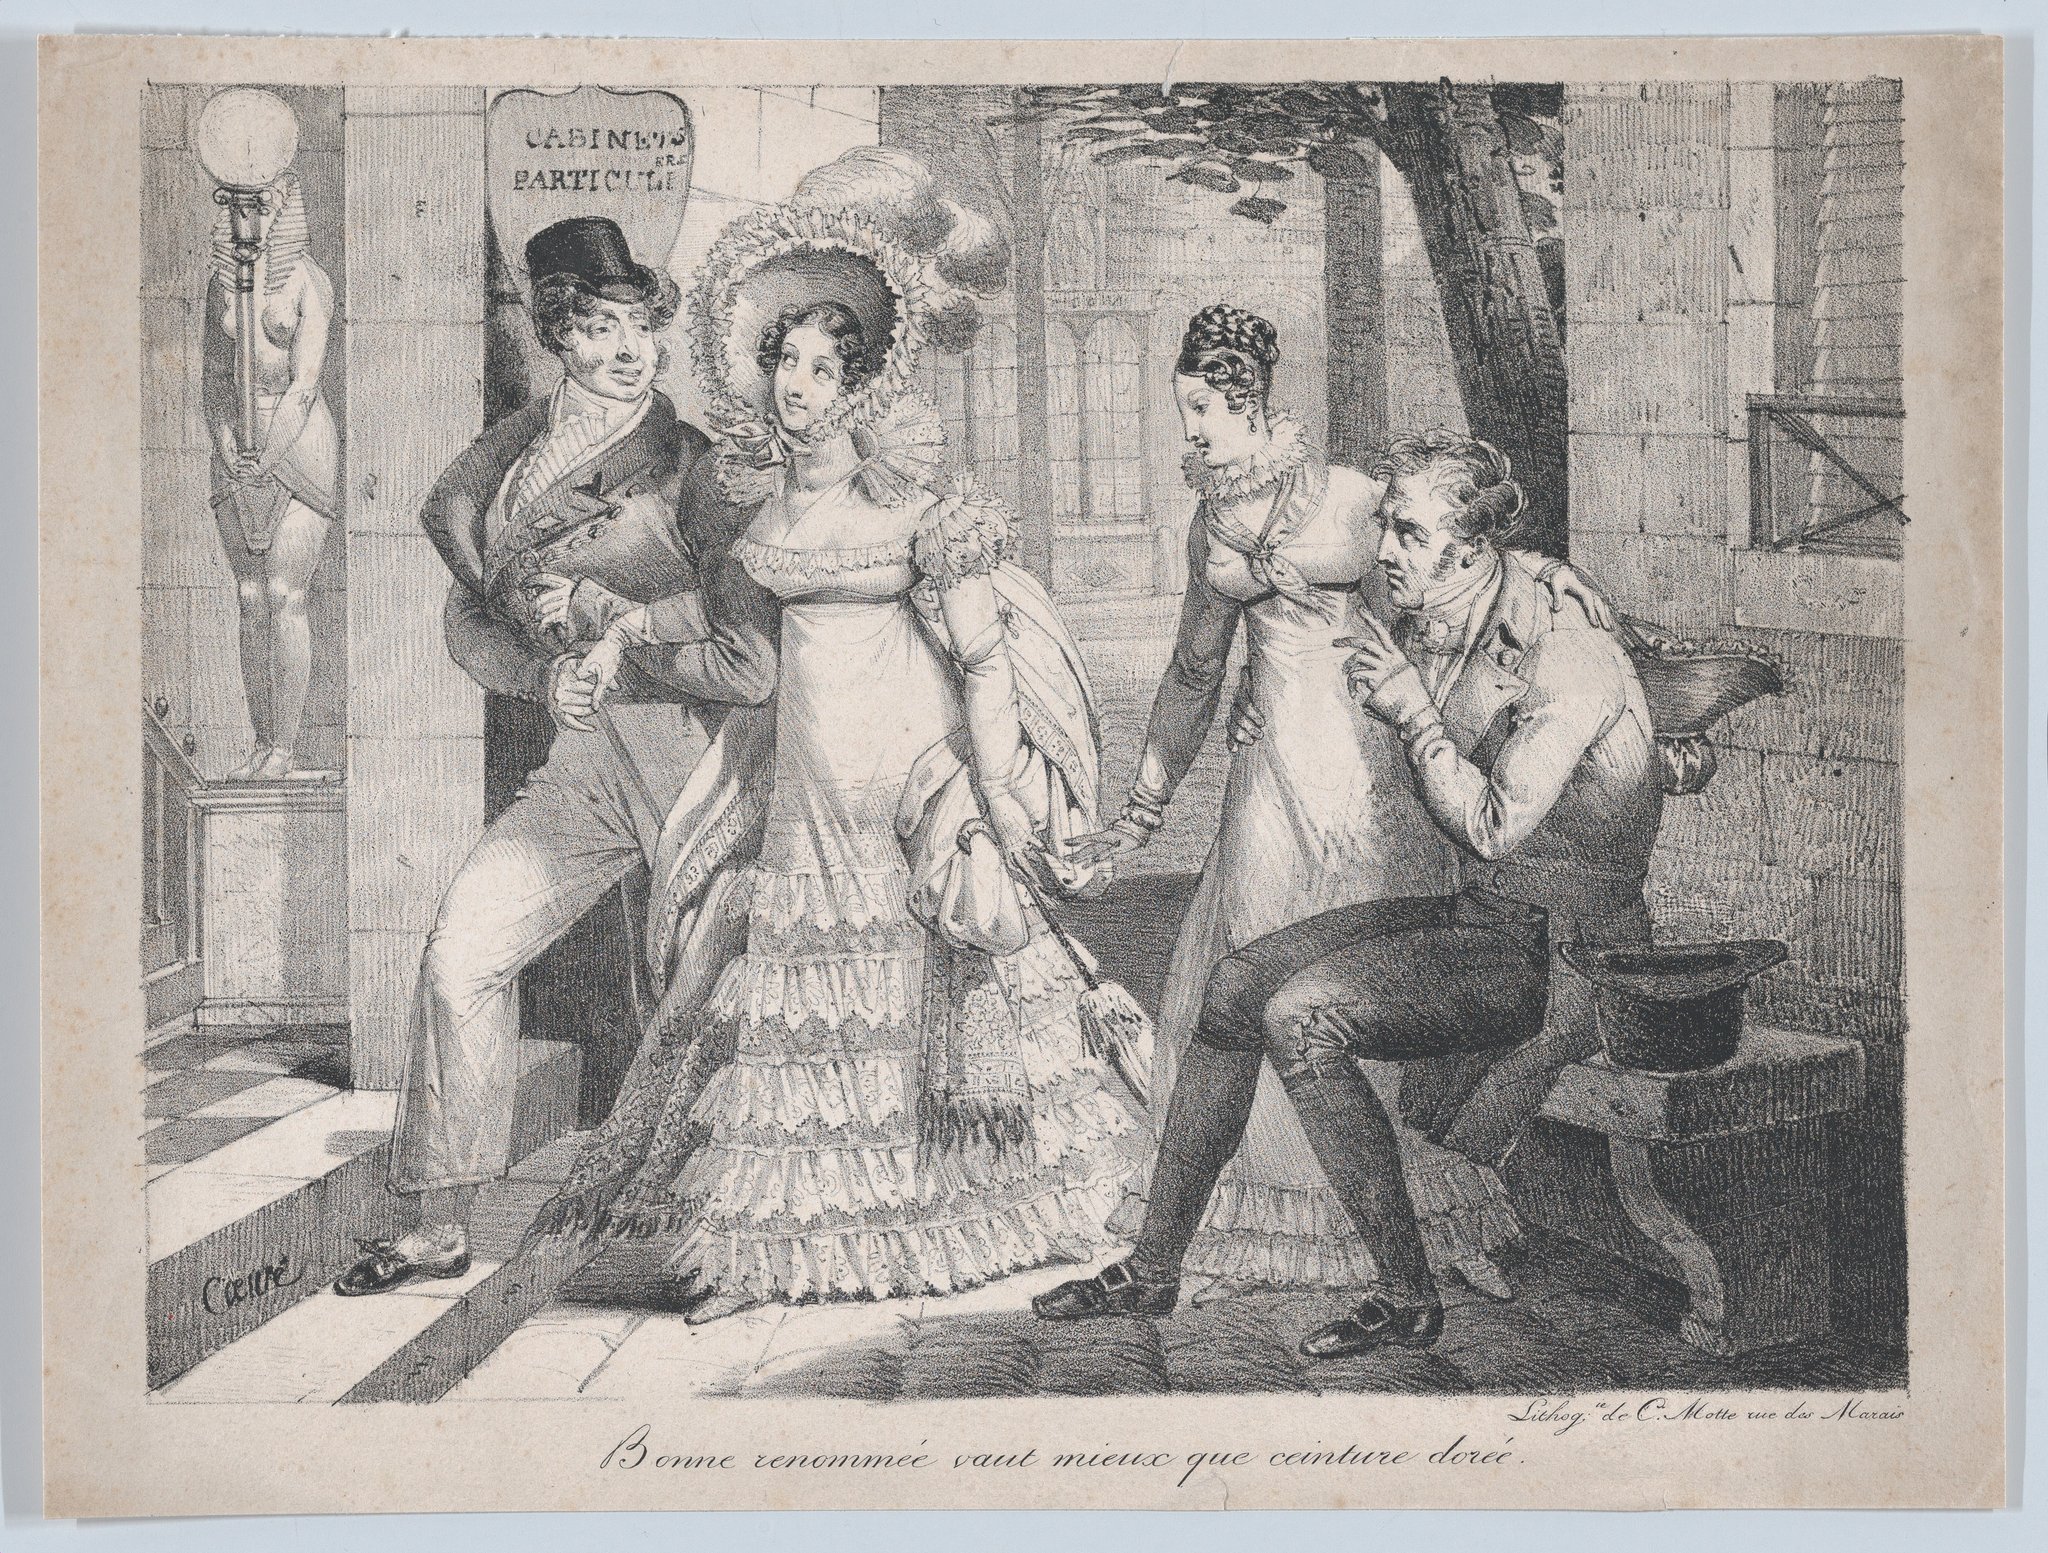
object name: print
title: Bonne renommée vaut mieux que ceinture dorée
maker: sébastien coeuré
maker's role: artist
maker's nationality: french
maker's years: 1778-1881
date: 1820-1830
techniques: lithograph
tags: couples,men,women